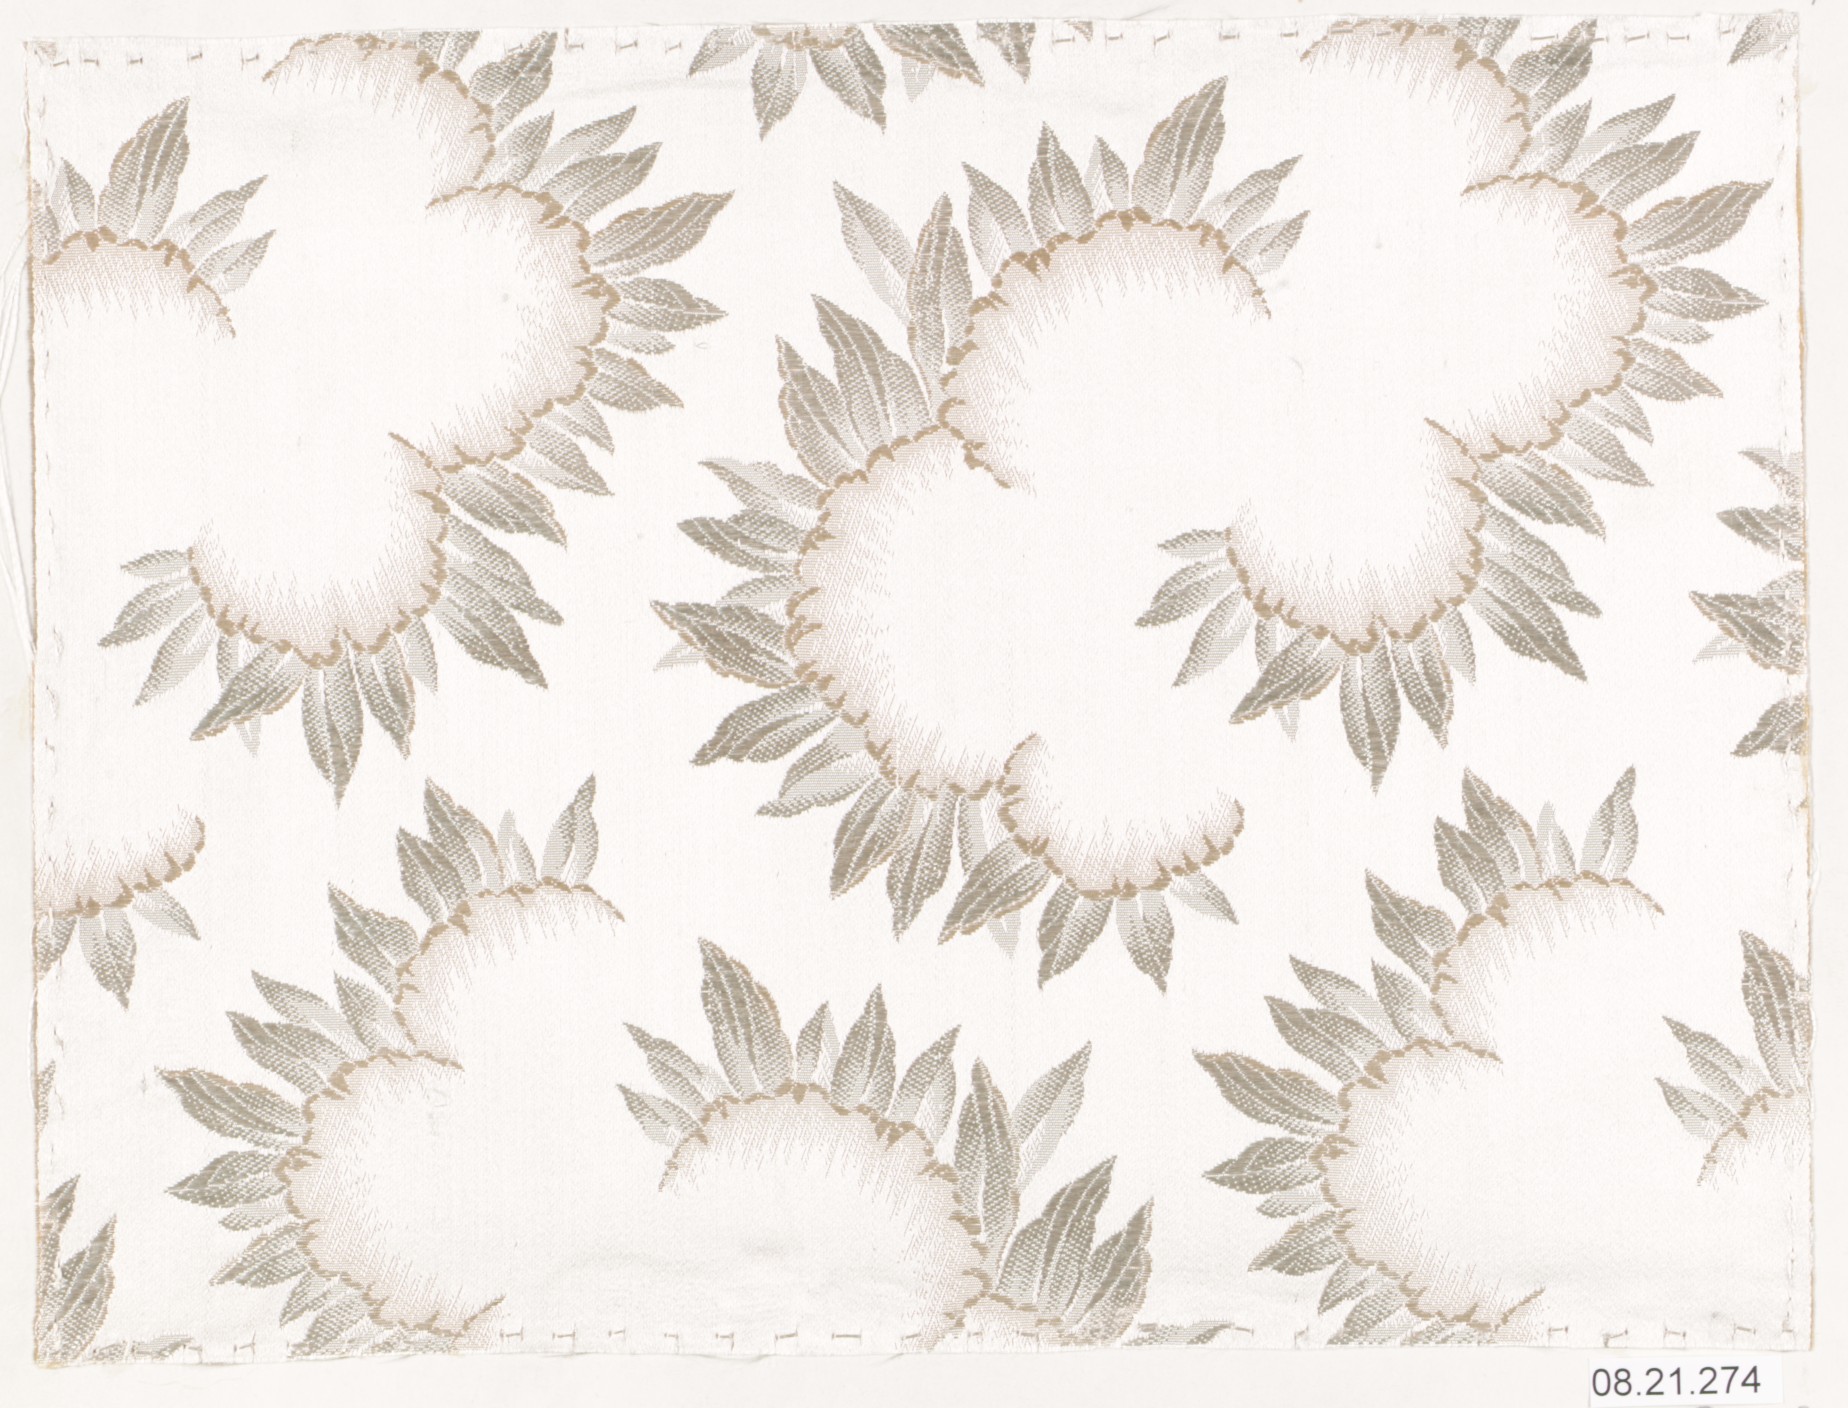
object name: textile sample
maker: Anonymous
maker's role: designer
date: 1900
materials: silk